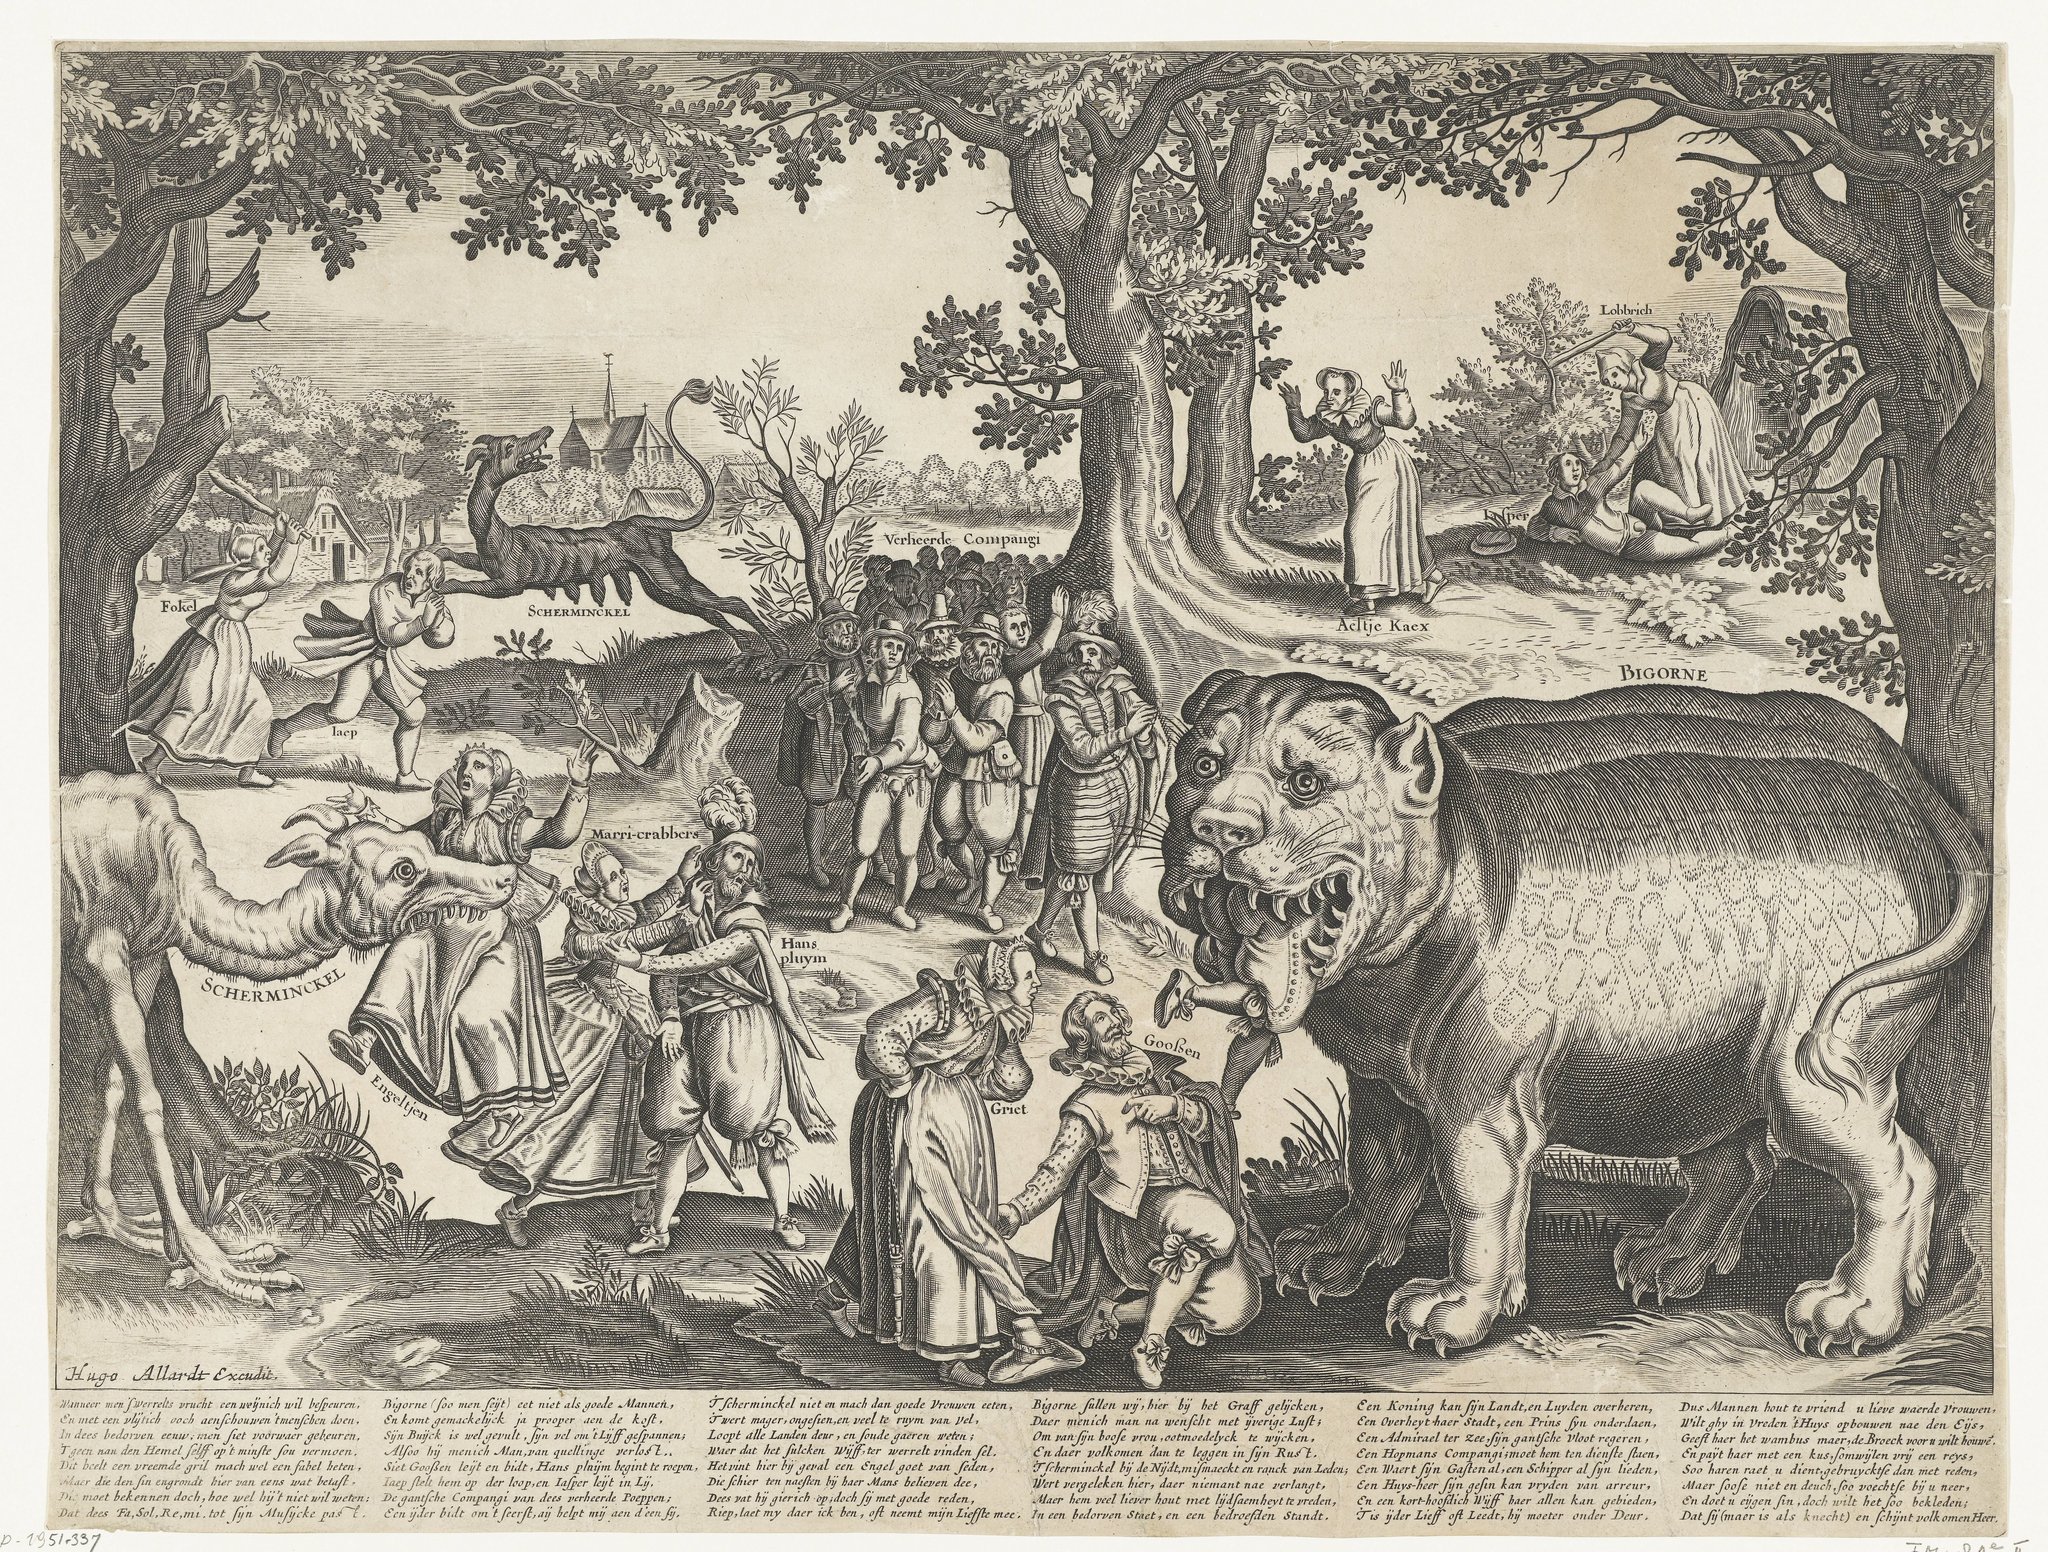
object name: print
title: Bigorne en Scherminckel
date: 1640-1680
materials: paper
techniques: engraving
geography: low countries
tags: bad wife, hen-pecked husband, 'bigorne et chiceface', mis-shapen animals; monsters, dominating wife, satire on marriage, ideal wife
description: Bigorne en Scherminckel. Voorstelling met de twee monsters Bigorne en Scherminckel. Magere Scherminckel eet alleen vrome vrouwen en dikke Bigorne alleen goede mannen. Hiertussen scènes van ruziemakende echtparen. Met onderschrift van 6 kolommen met elk 8 regels in het Nederlands.